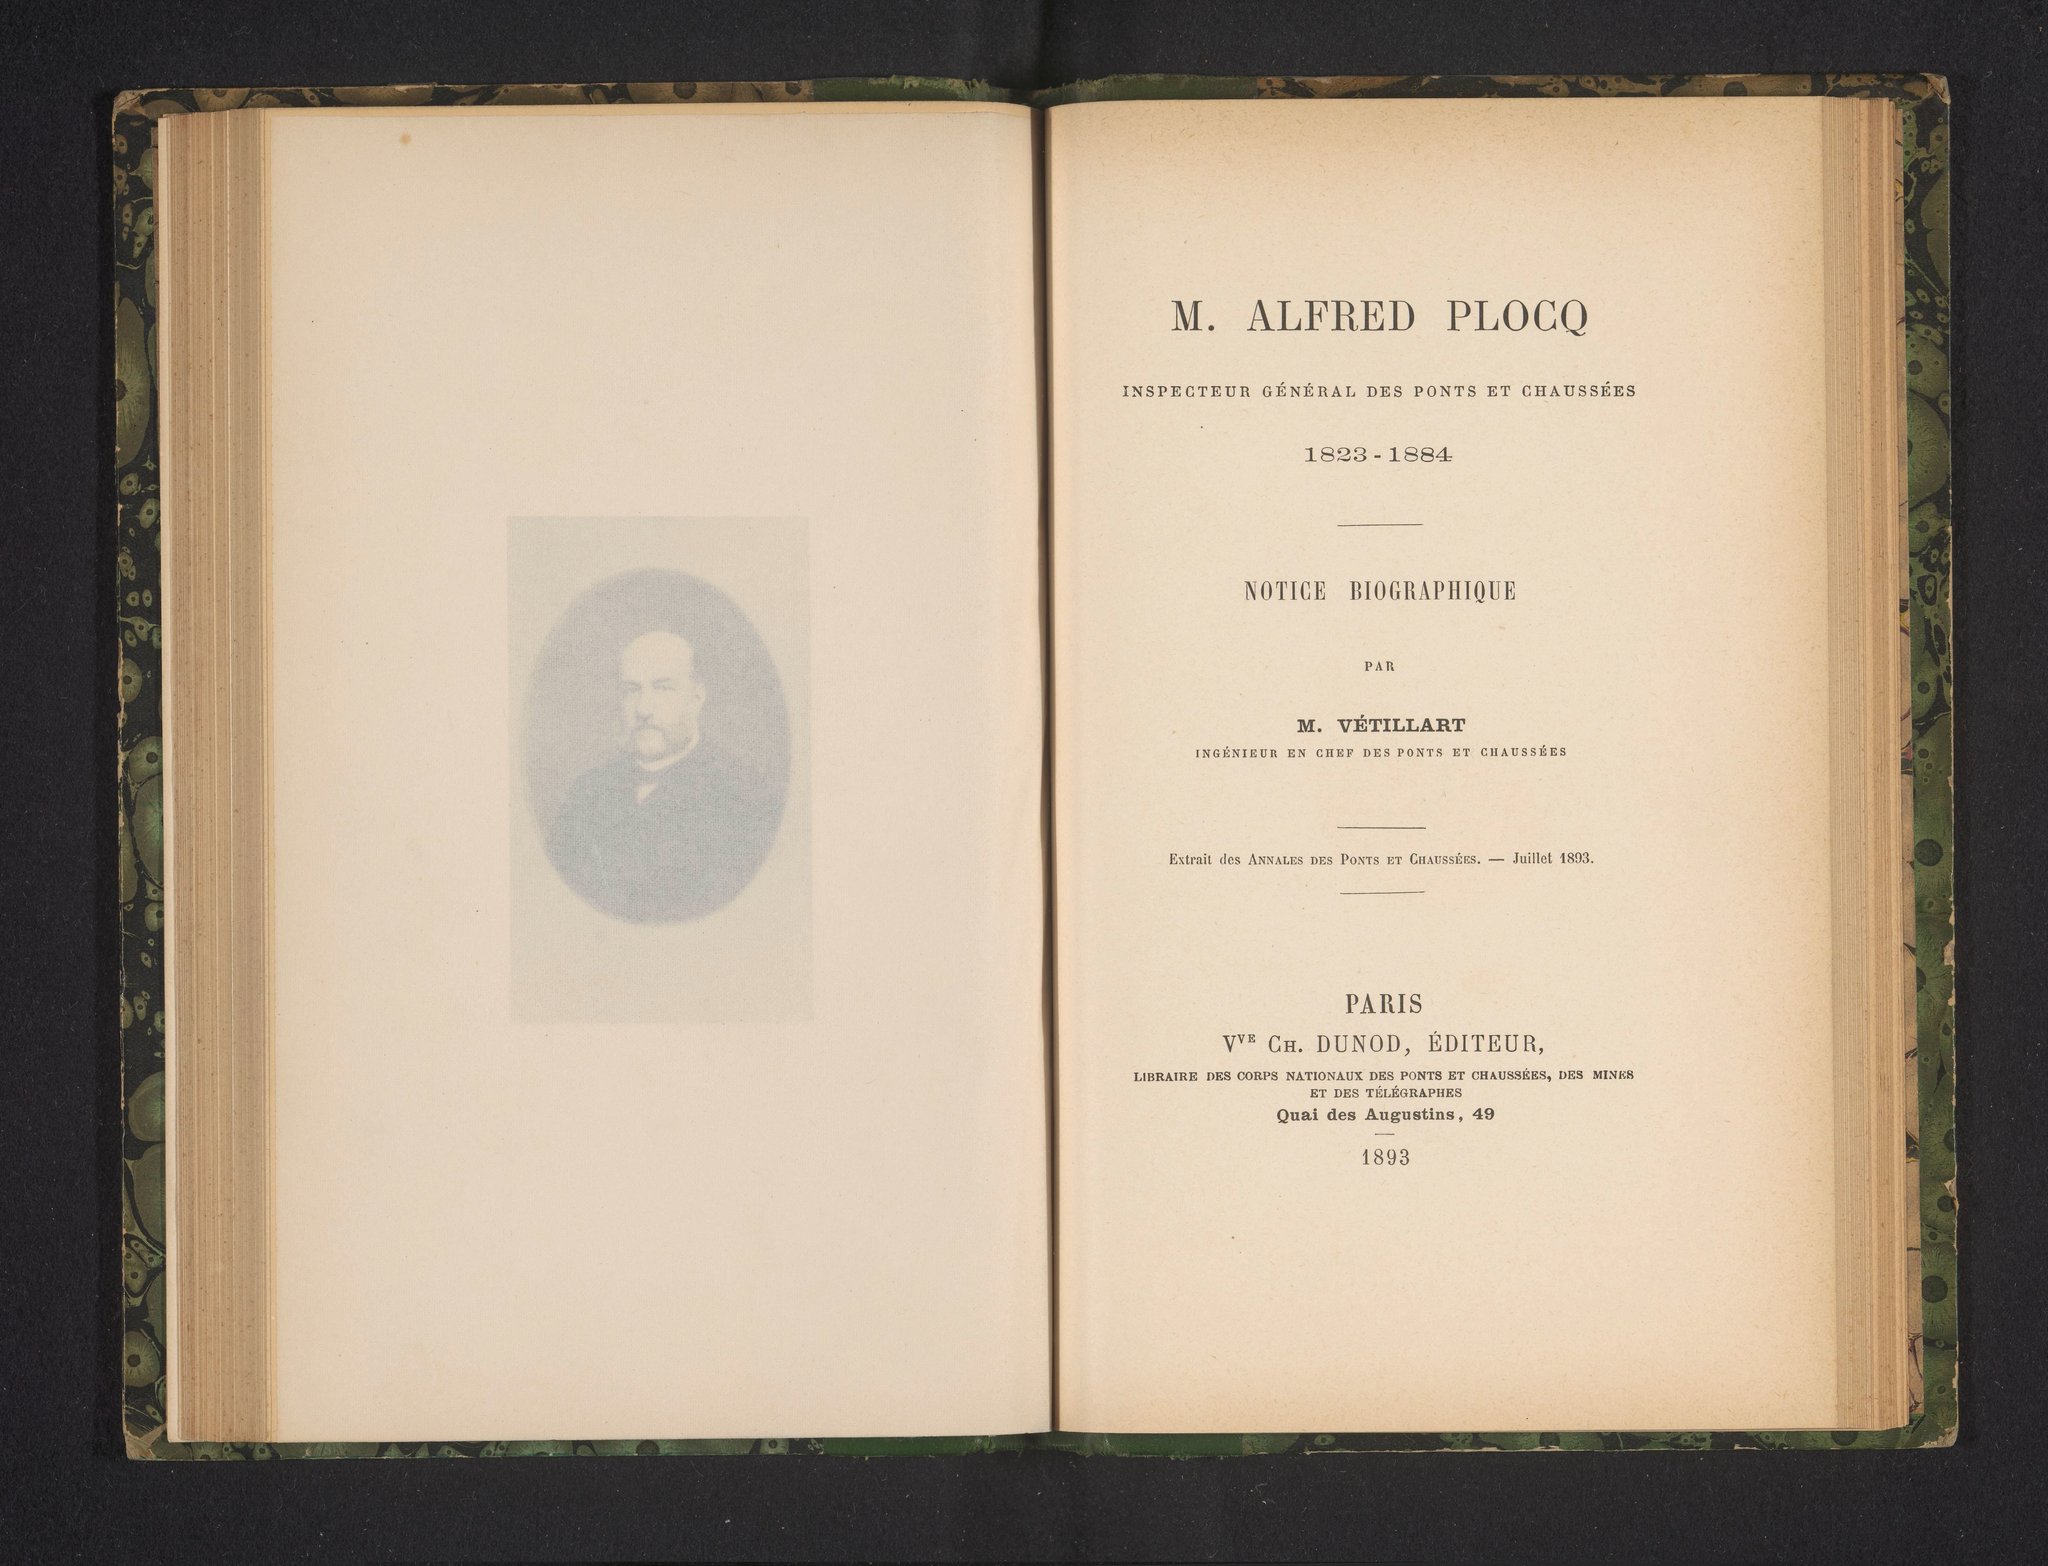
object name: book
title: M. Alfred Plocq, inspecteur général des ponts et chaussées 1823-1884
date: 1893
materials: linen, paper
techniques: photograph, printing, marbled paper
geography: paris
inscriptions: annotation: ‘ex-W. [...]/ 1993’